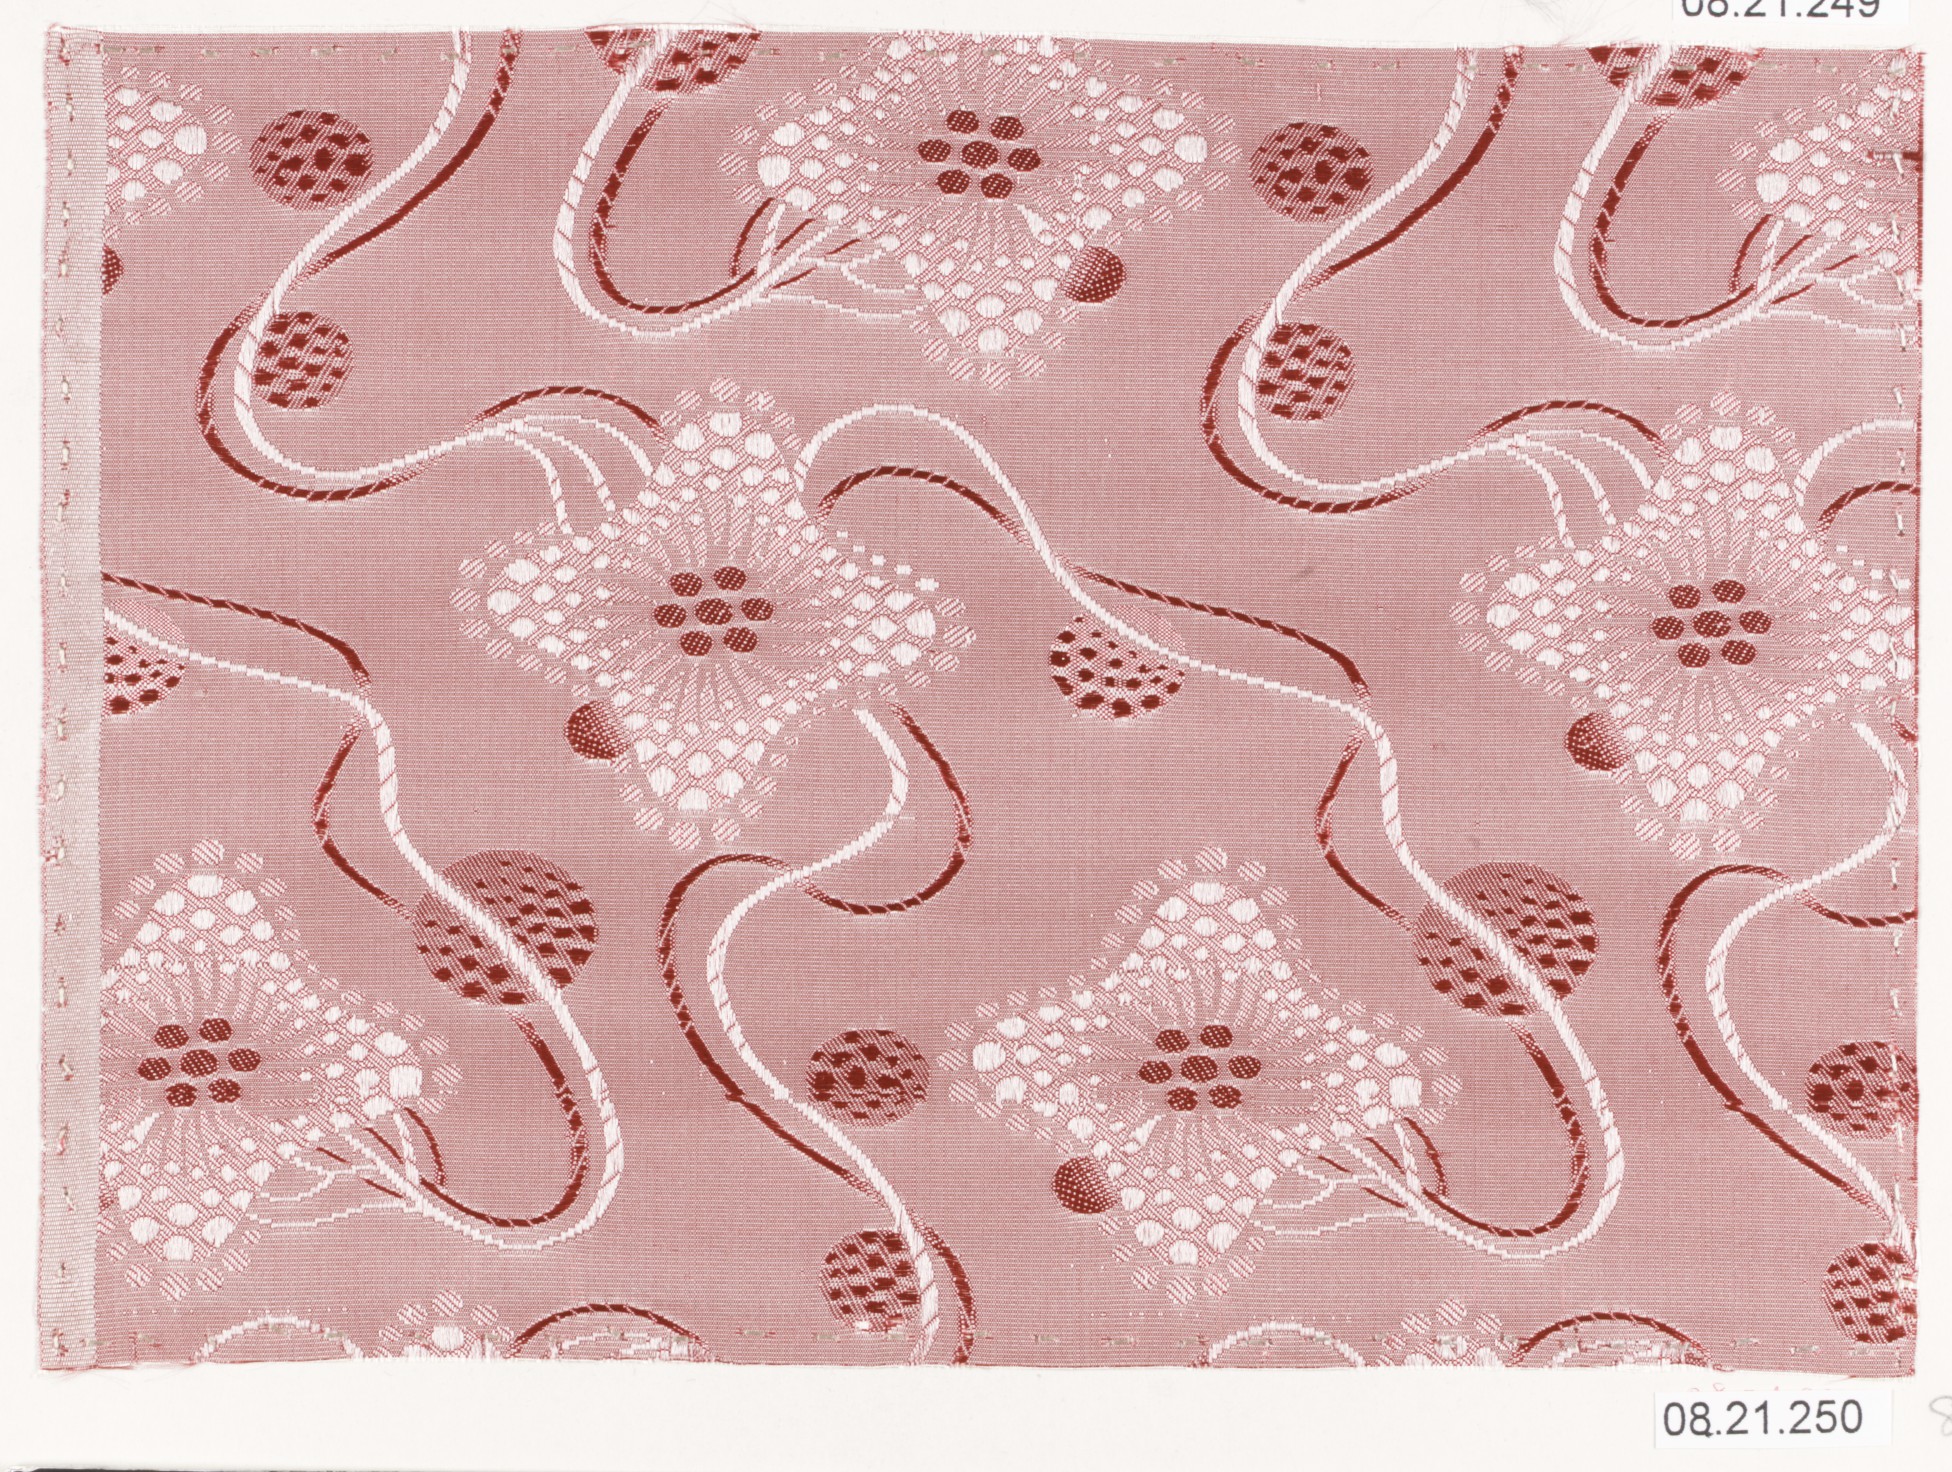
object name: textile sample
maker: Anonymous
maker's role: designer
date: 1900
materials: silk